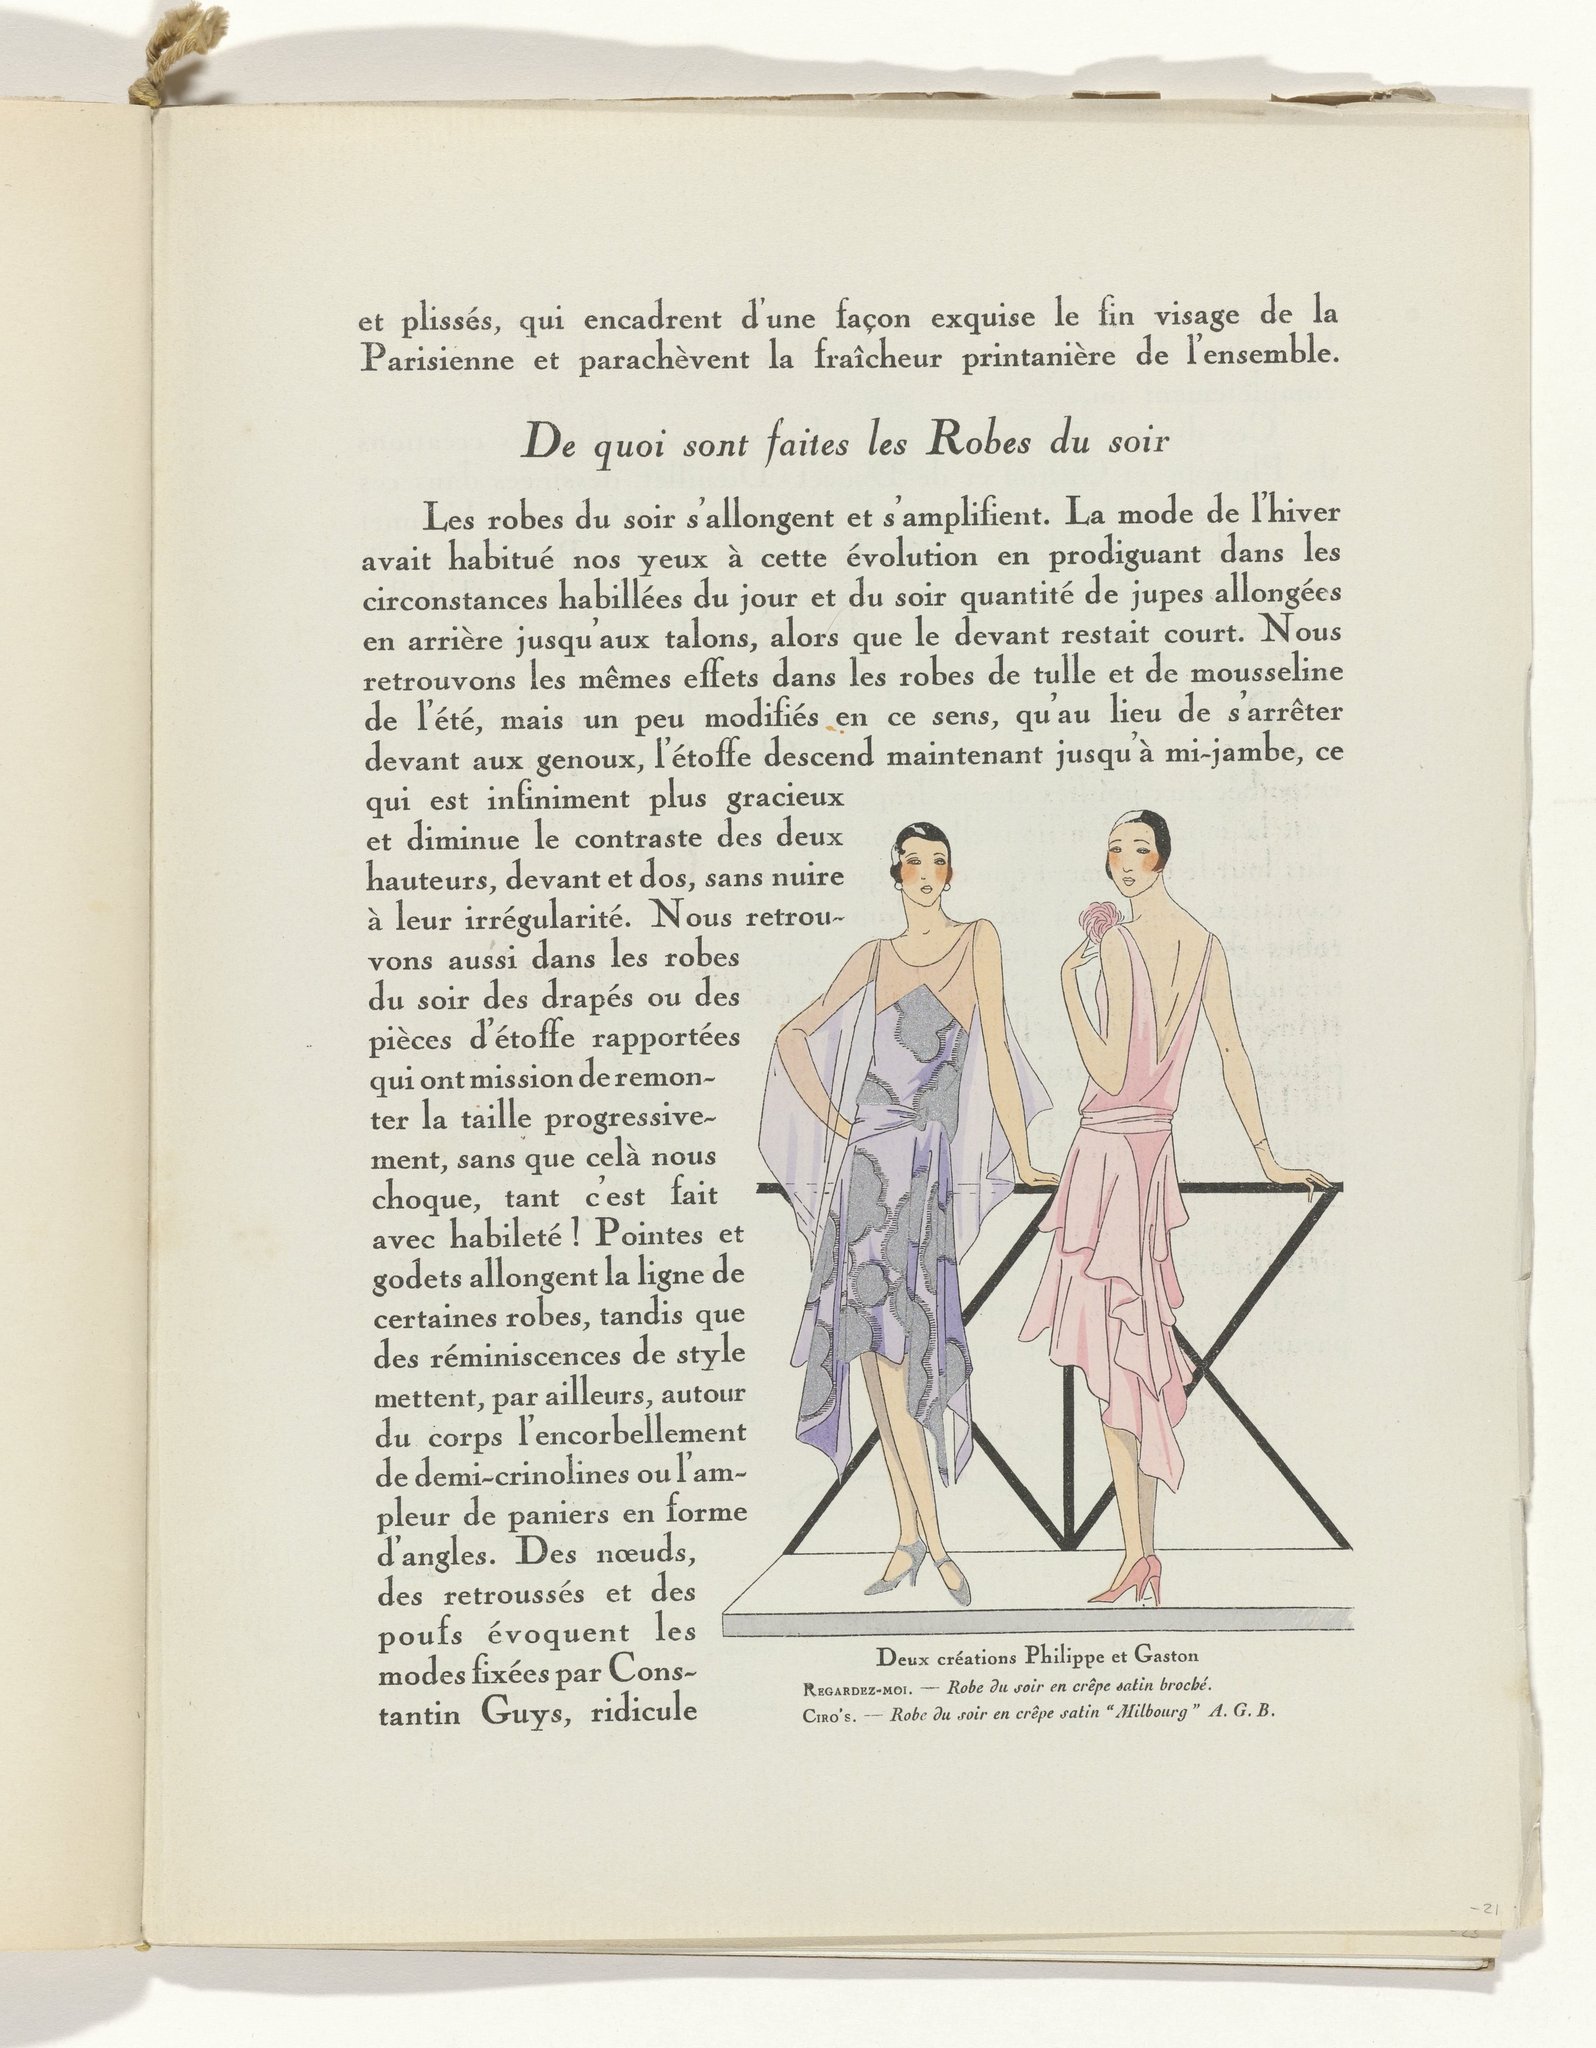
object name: fashion print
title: Art - Goût - Beauté, Feuillets de l' élégance féminine, Mars 1929, No. 103, 9e Année, p. 21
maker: charles goy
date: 1929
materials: paper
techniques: brush, hand coloring, lithograph, pochoir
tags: dress, gown: evening dress (+ women's clothes), fashion plates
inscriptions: caption: ‘Deux créations Philippe et Gaston / REGARDEZ-MOI. - Robe du soir en crêpe satin broché. / CIRO'S.- Robe du soir en crêpe satin "Milbourg" A.G.B.’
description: Tekst met titel "De quoi sont faites les Robes du Soir". Afbeelding van twee avondjurken van Philippe et Gaston: 'Regardez-moi" en "Ciro's". Pagina uit het modetijdschrift Art-Goût-Beauté (1920-1933).